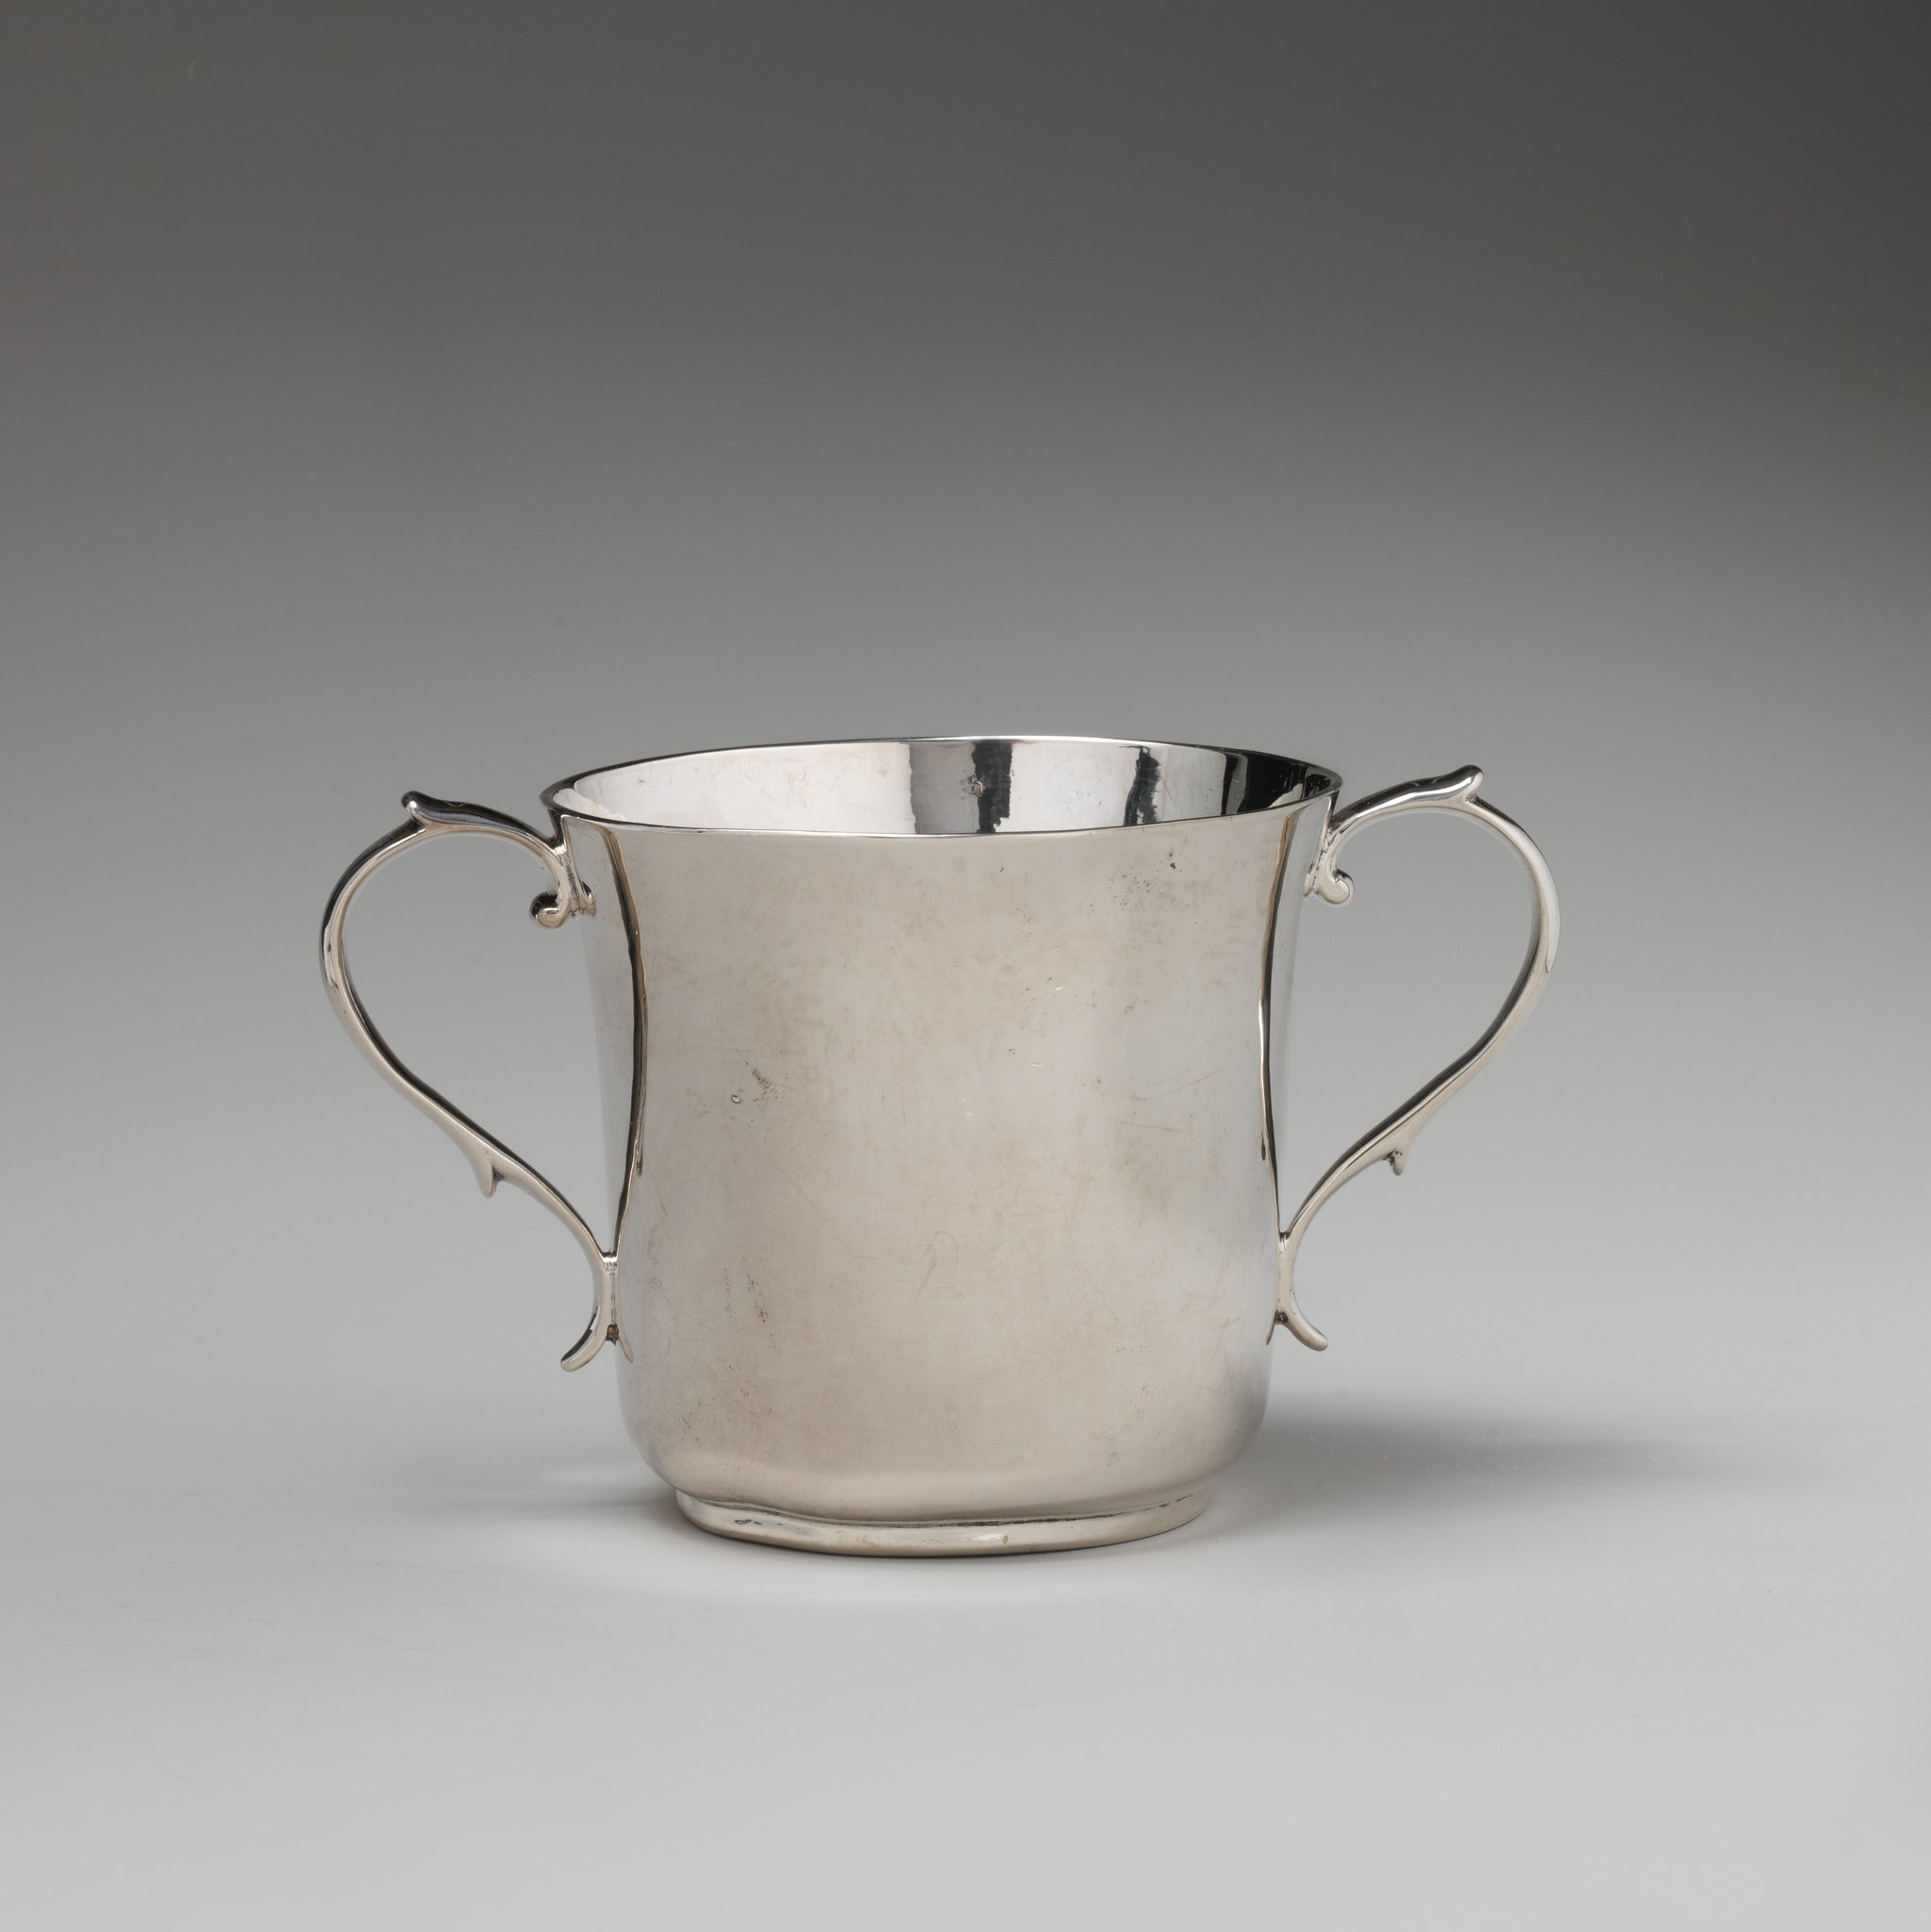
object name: cup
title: Two-handled cup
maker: r. m., london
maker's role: maker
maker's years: 1651-1662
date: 1661-1662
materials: silver